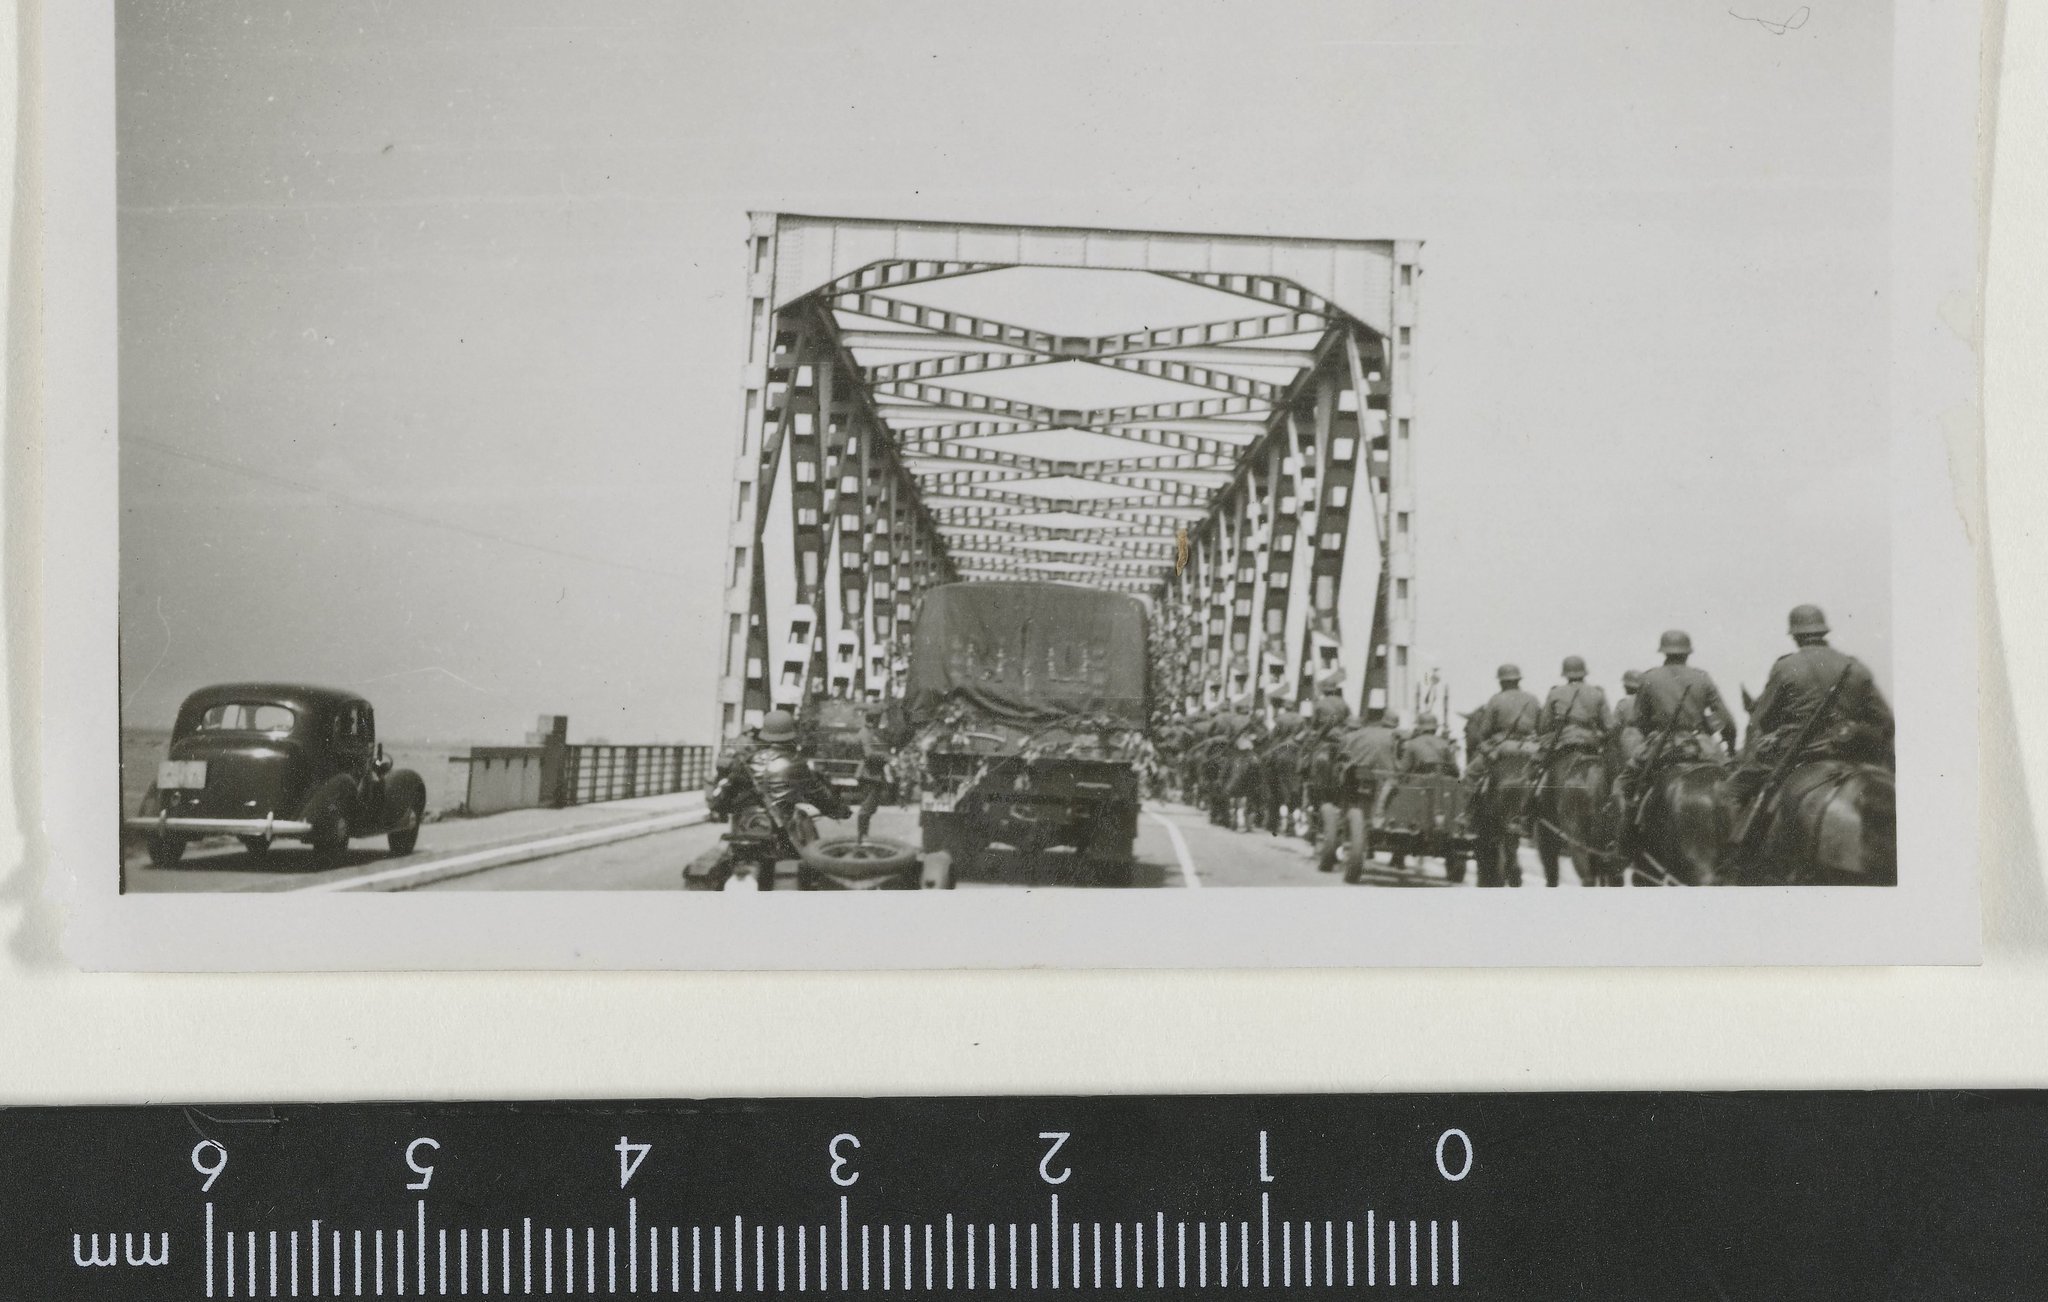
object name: photograph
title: De Wehrmacht trekt over de Moerdijkbrug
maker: Anonymous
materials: photographic support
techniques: gelatin silver print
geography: netherlands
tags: troop movements, transportation, occupation ~ war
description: Een Duitse militaire colonne van de Wehrmacht trekt over een brug Nederland binnen. Rechts militairen op paarden, in het midden militaire voertuigen. Het zou de Moerdijk brug kunnen zijn. Links rijdt een civiele auto.